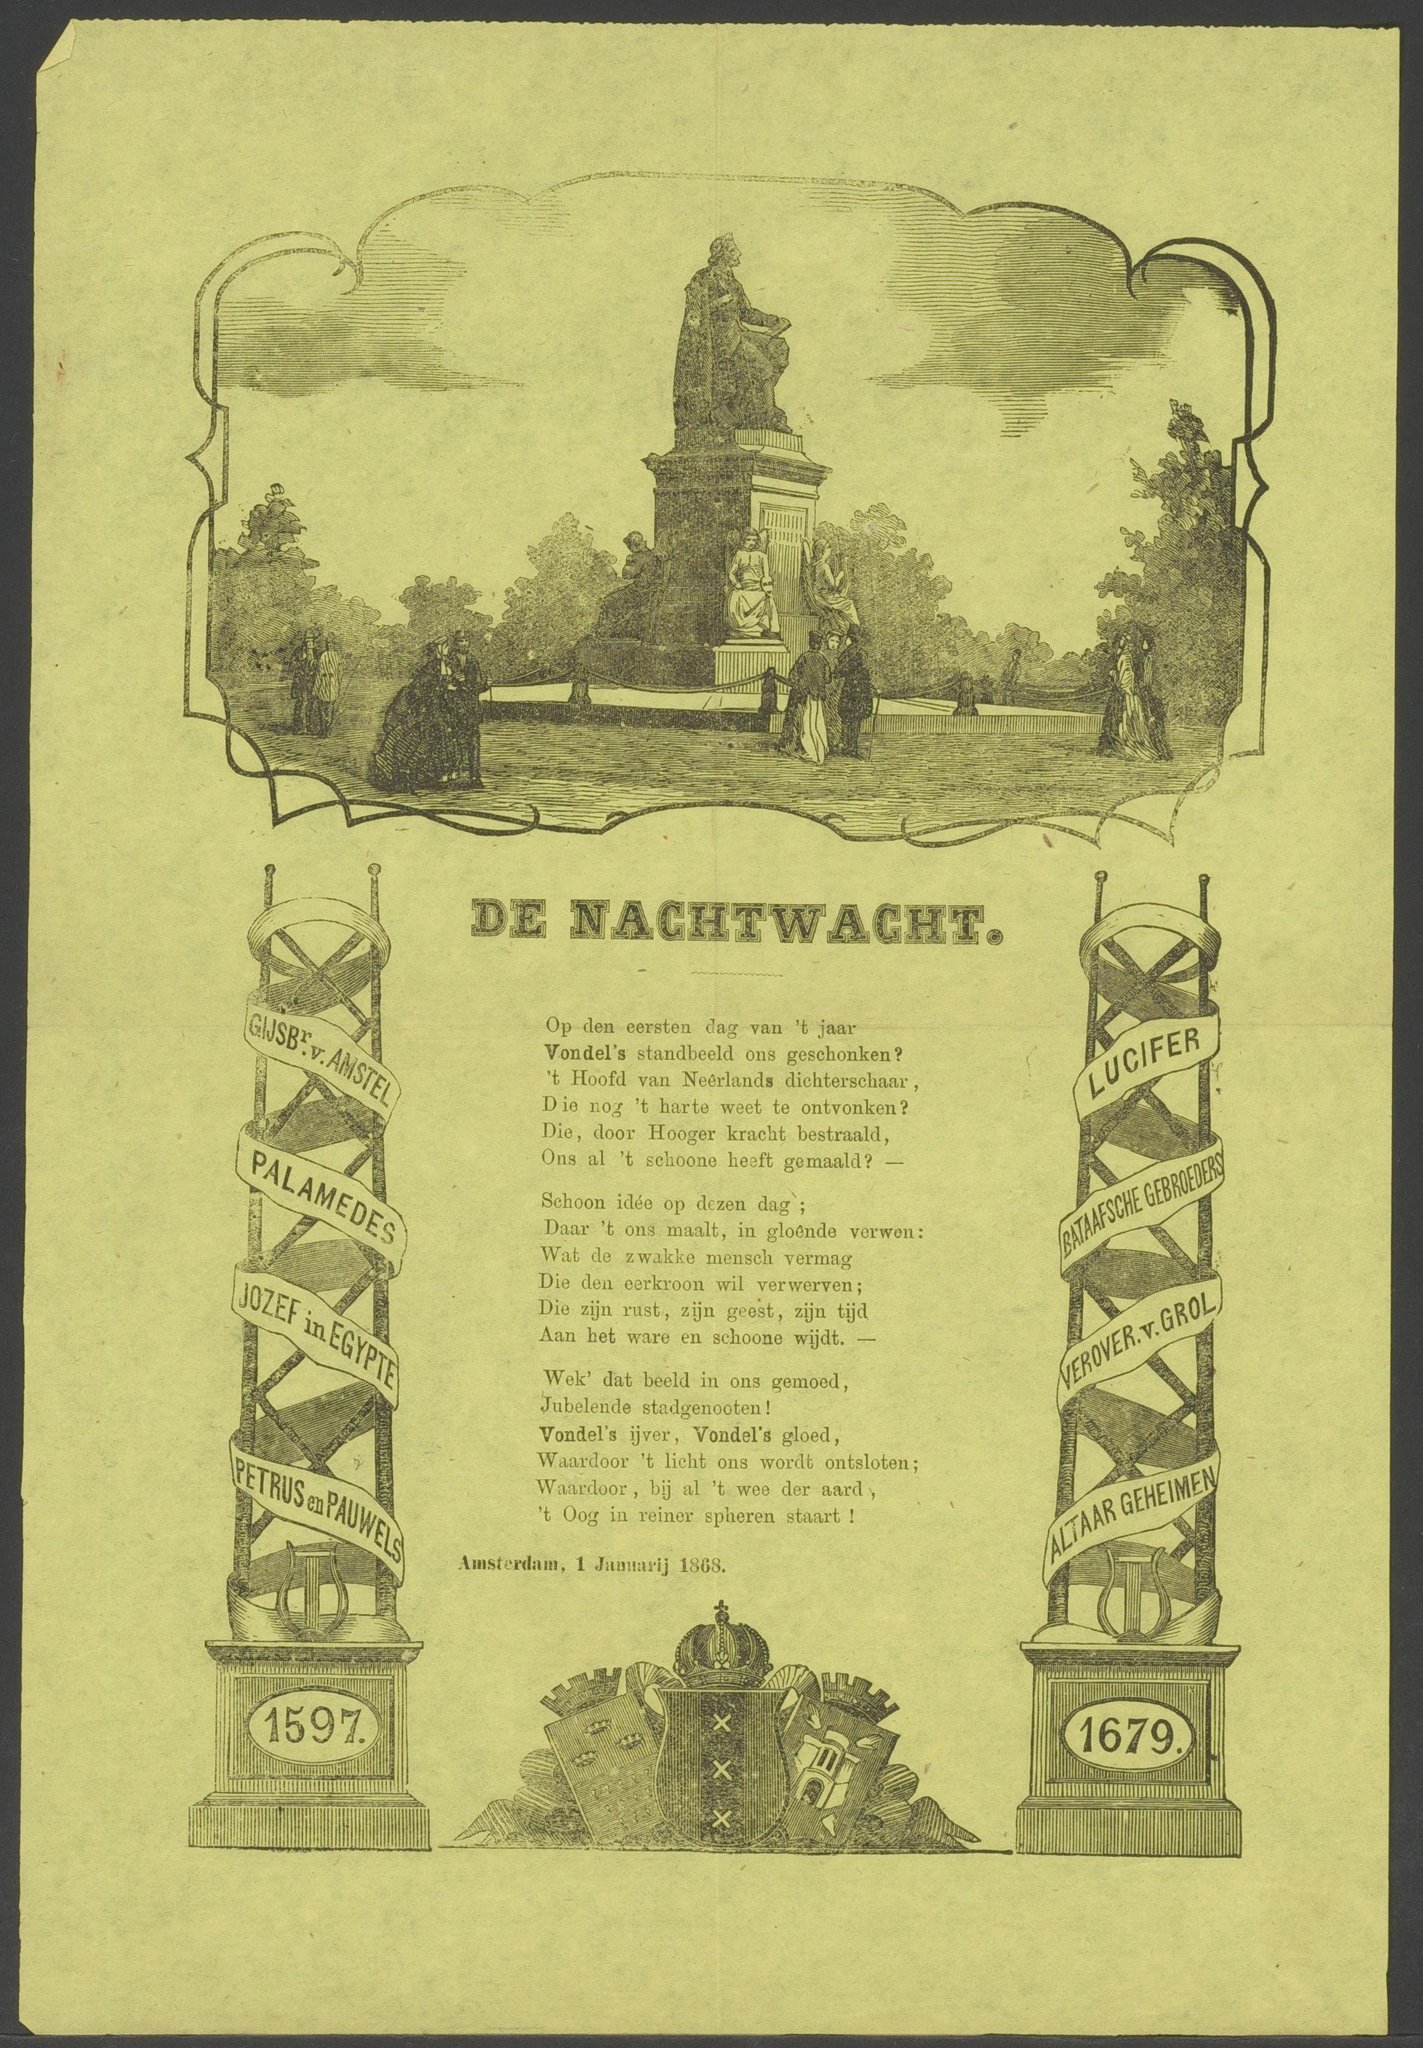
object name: print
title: De Nachtwacht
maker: Anonymous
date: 1867-1868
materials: paper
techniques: letterpress printing, engraving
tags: amsterdam, joost van den vondel, night patrol, coat of arms (as symbol of the state, etc.) (+ city; municipal), theatre, theatrical performance, monument, statue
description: Nieuwjaarswens van de Amsterdamse nachtwacht (ratelwacht) voor het jaar 1868. Onderaan een gedicht, bovenaan een standbeeld van Joost van den Vondel. Naast het gedicht twee stellages met een banier met de titels van verschillende toneelstukken van Vondel. Onderaan de geboorte en sterfdatum van Vondel. Onderaan het wapen van Amsterdam. Onderwerpsrubrieken binnen de Atlas Zeden en Gewoonten: Zeden en gewoonten in engeren zin, Volksleven, Volksbladen, Nieuwjaars- en Kerstwenschen, Amsterdam.